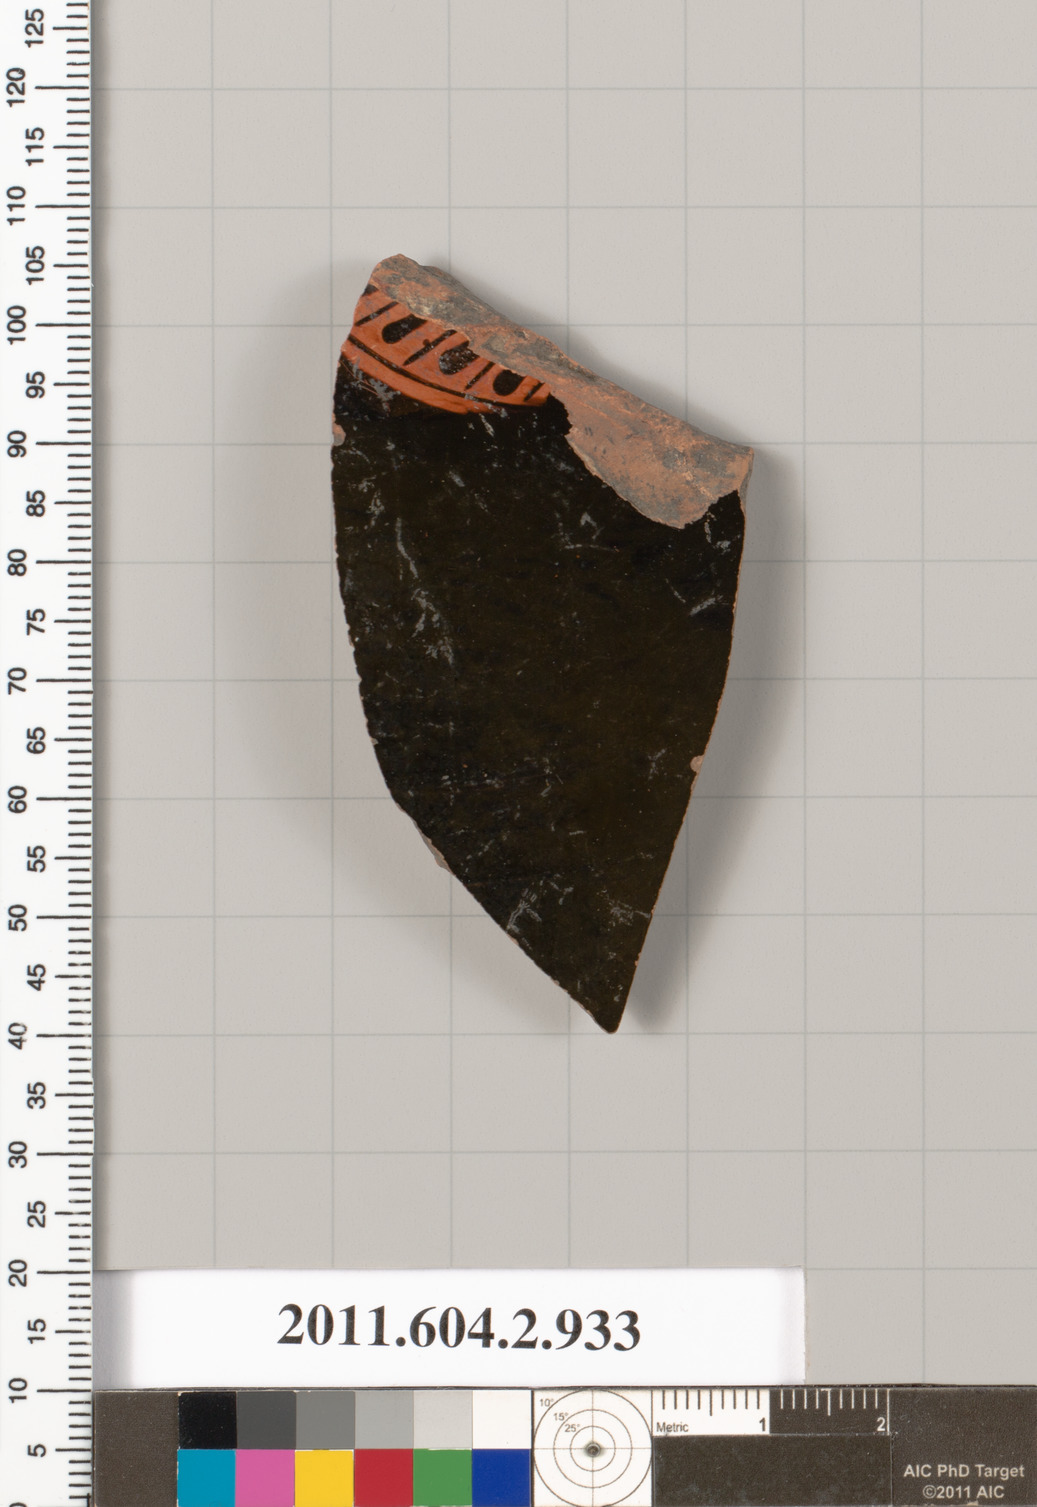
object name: kalpis fragment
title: Terracotta fragment of a hydria: kalpis (water jar)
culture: greek, attic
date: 467-435 BCE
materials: terracotta